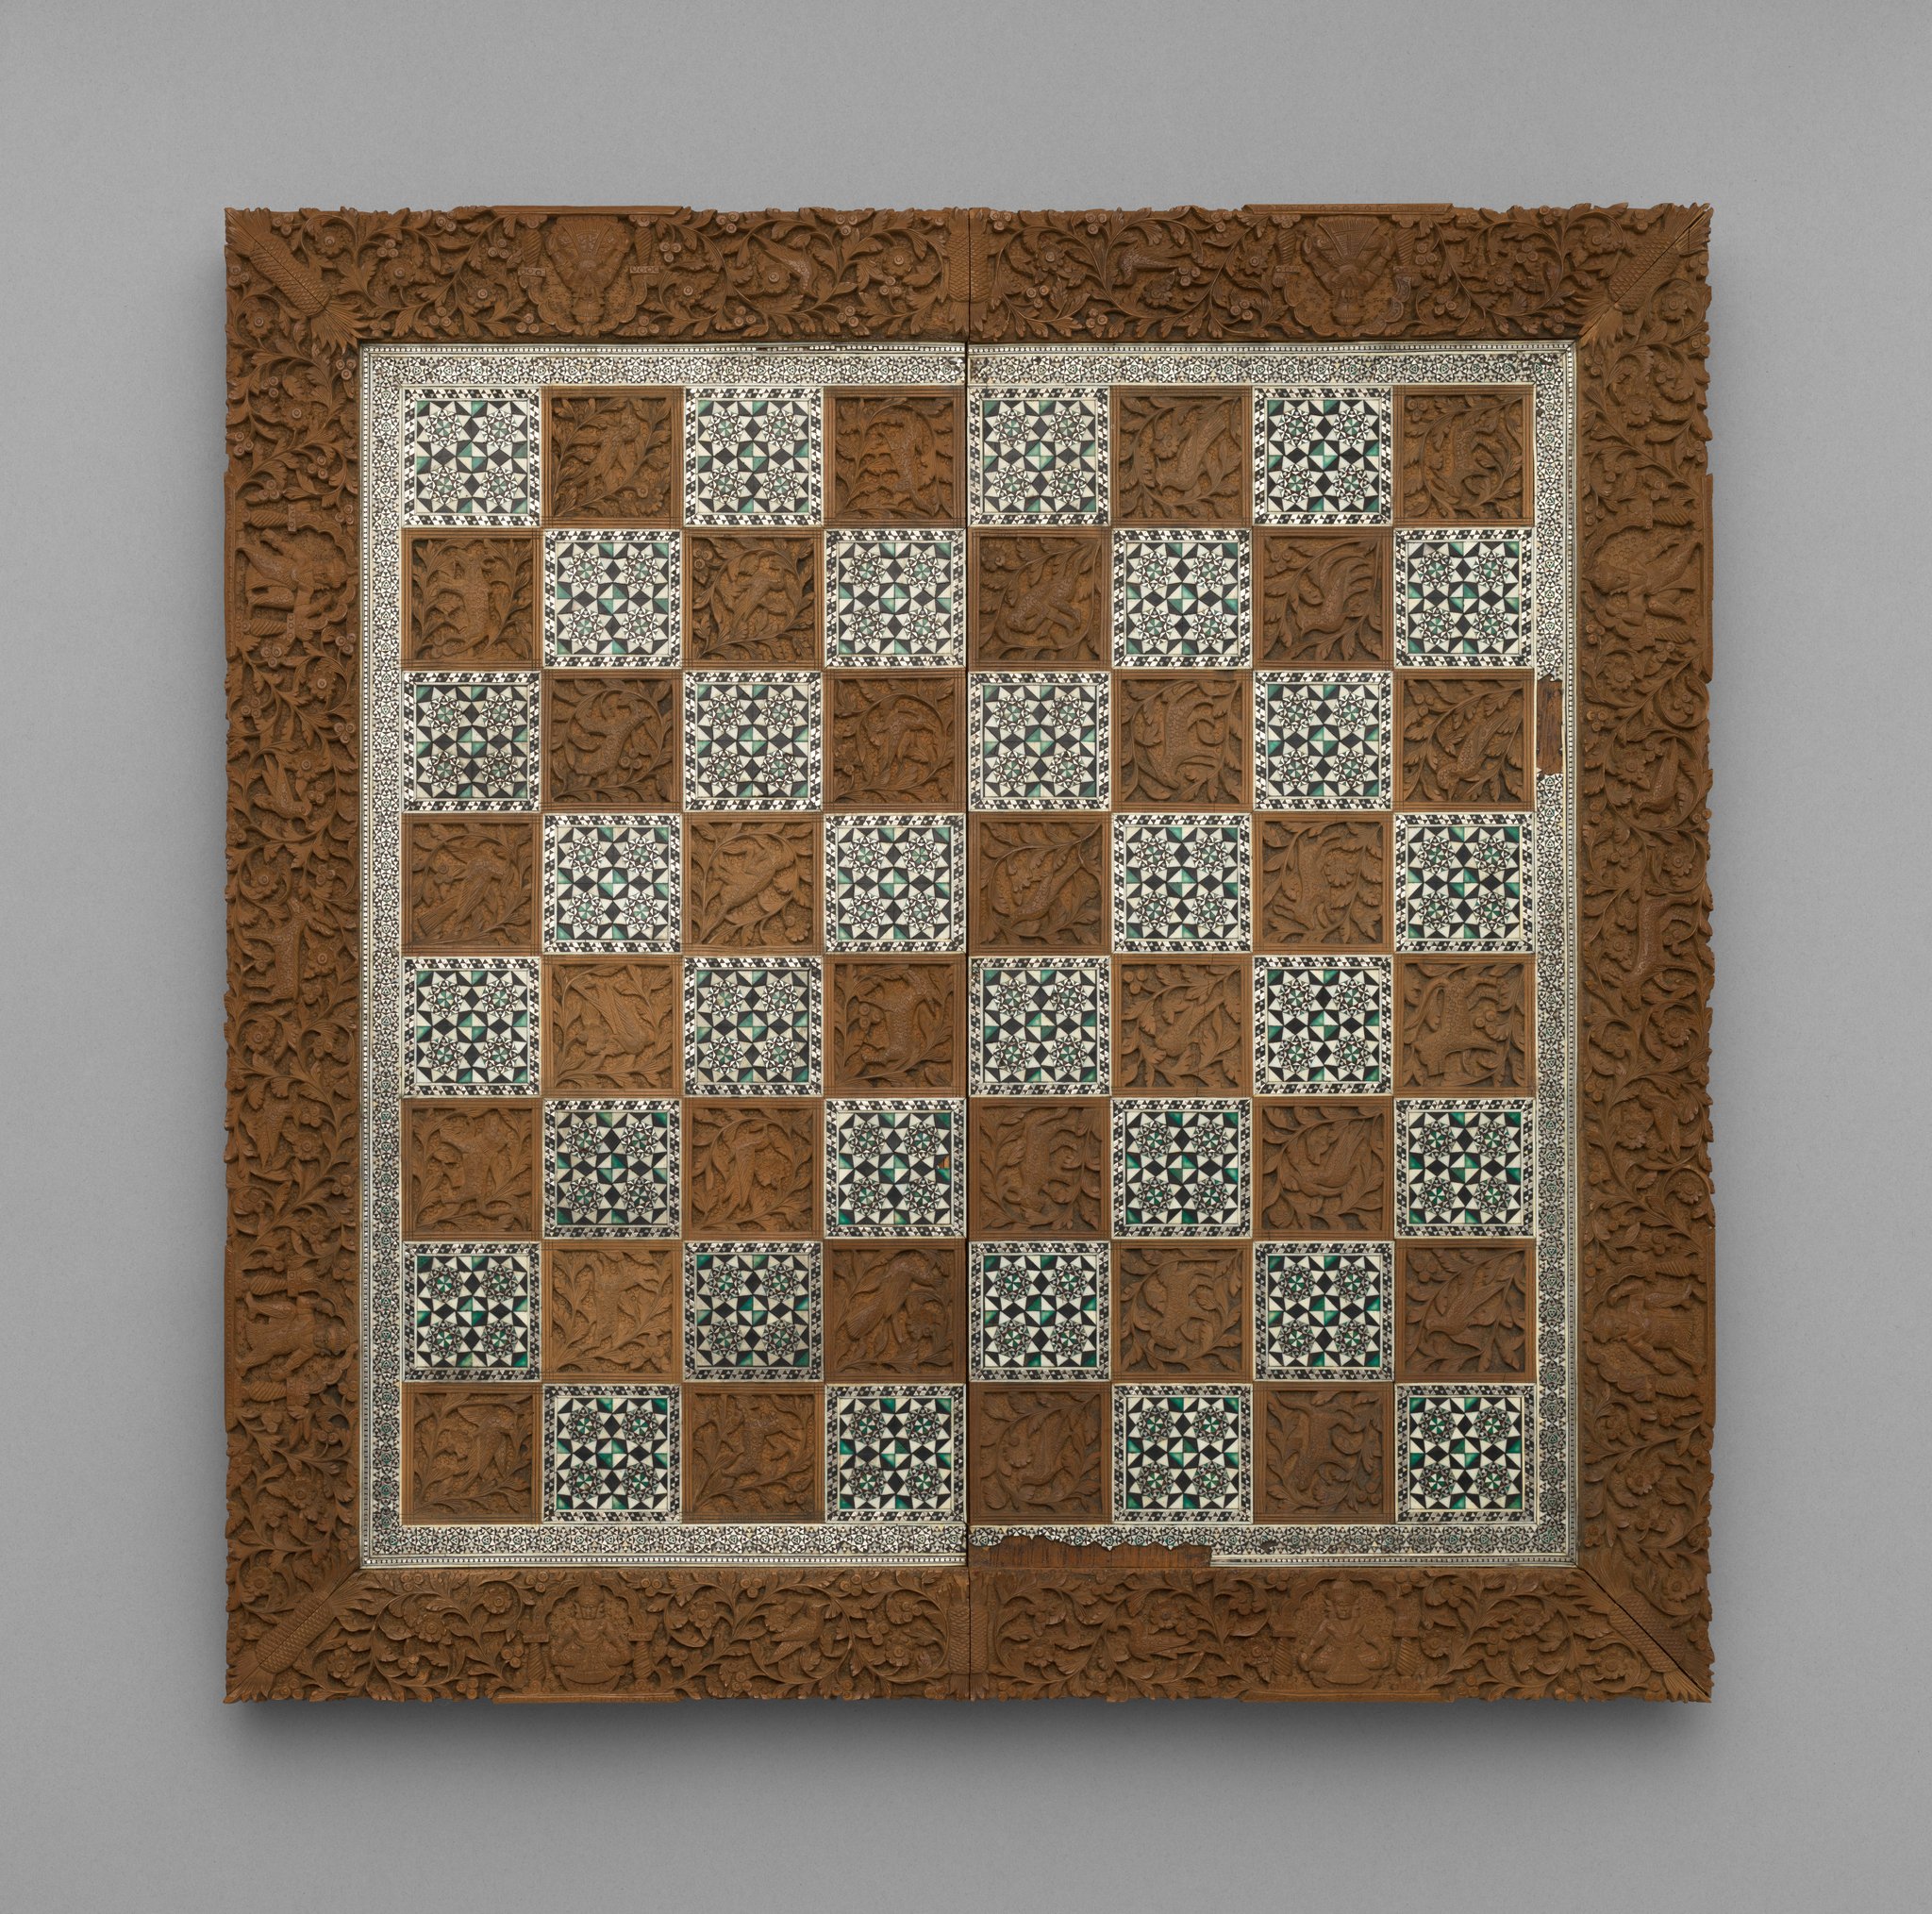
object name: chess and backgammon board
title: Box-board for chess and backgammon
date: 1801-1900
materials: ivory, silver, wood